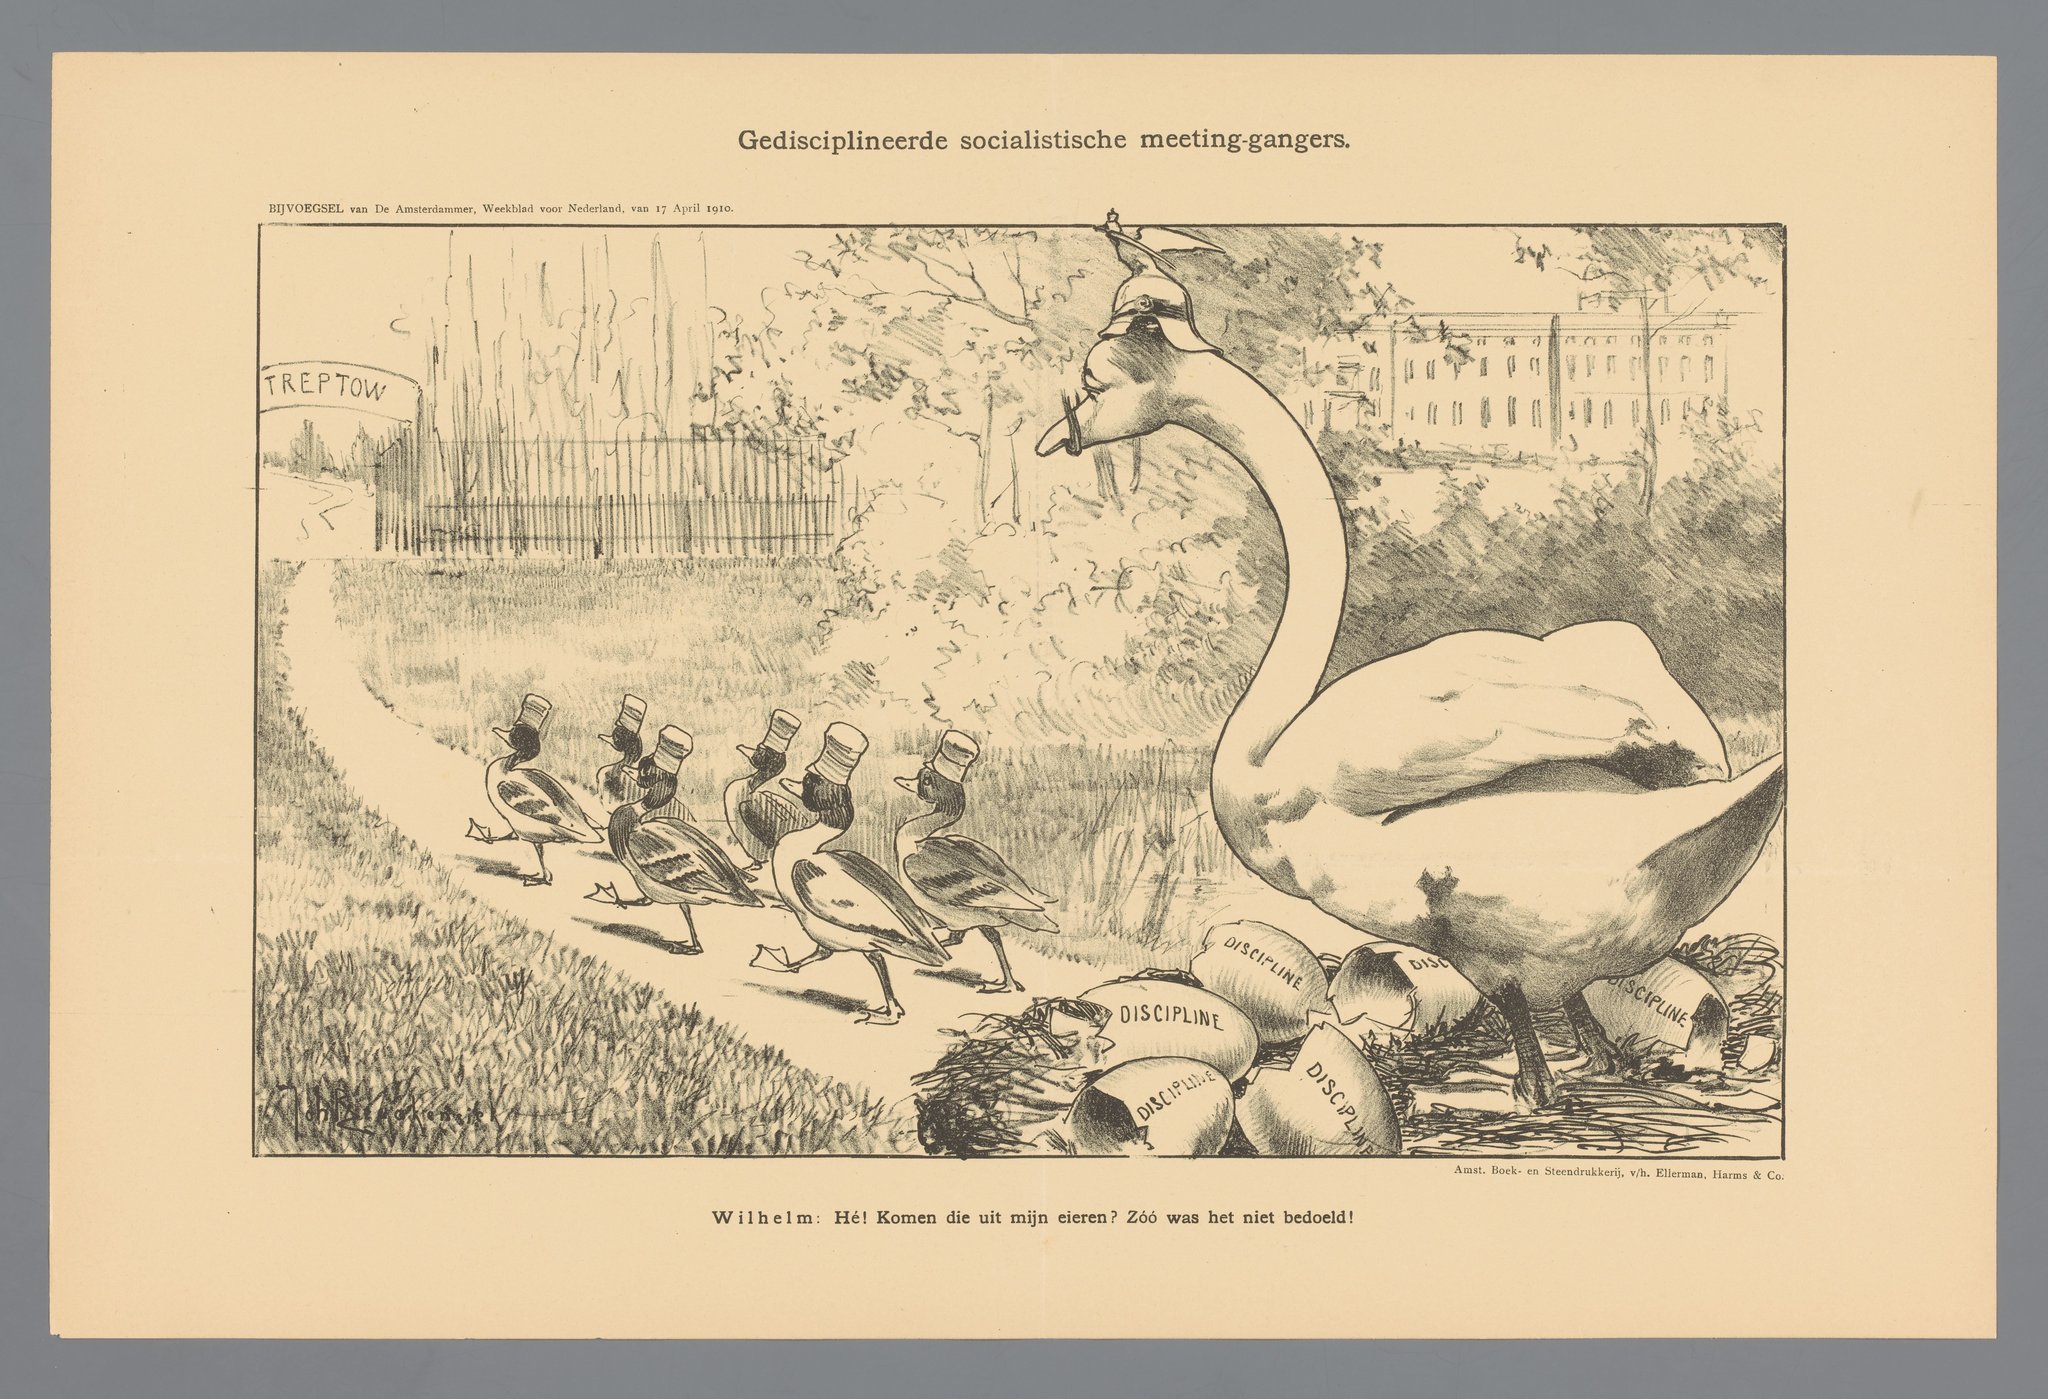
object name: cartoon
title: Gedisciplineerde socialistische meeting-gangers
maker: johan braakensiek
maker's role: draughtsman, print maker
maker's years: 1858-1940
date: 1910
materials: paper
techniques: lithograph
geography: amsterdam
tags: wilhelm ii (keizer van duitsland), water-birds: swan, historical persons, political caricatures and satires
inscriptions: date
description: Prent uit het bijvoegsel van: De Amsterdammer. Weekblad voor Nederland, 17 april 1910.